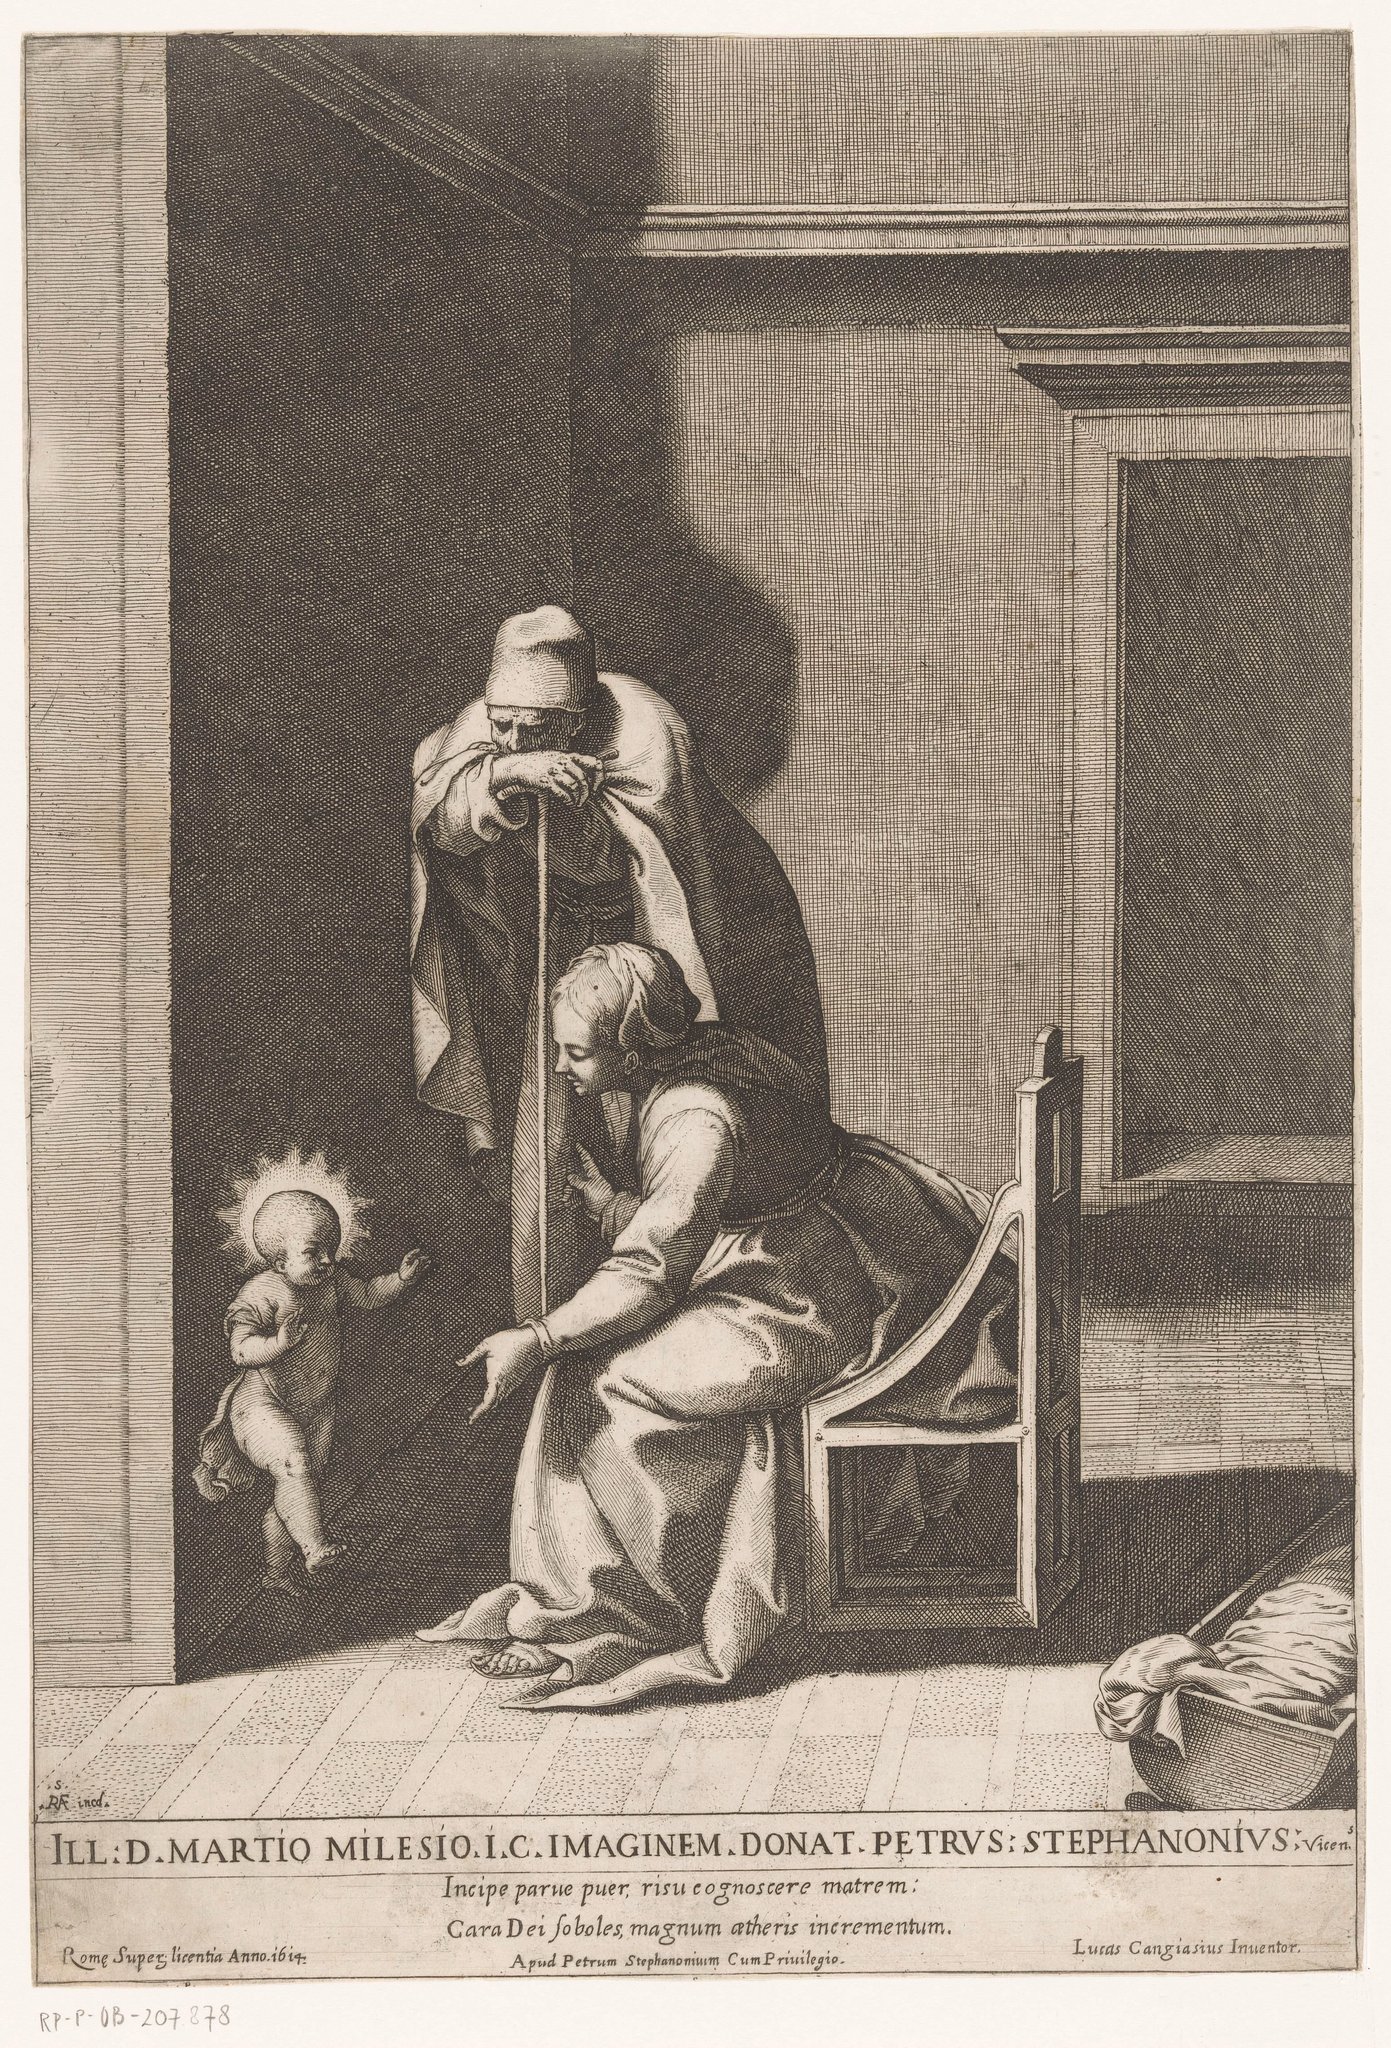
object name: print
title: Maria leert het Christuskind lopen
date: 1614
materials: paper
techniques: etching, intaglio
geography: italy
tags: christ-child walking the first steps (in nazareth)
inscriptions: collector's mark: Lugt 2228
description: In een interieur zit Maria op een stoel, haar arm uitgestrekt richting het Christuskind. Links staat het Kind met de handen in de lucht en met één been van de grond om een stap te zetten. Jozef staat achter hen en kijkt toe.